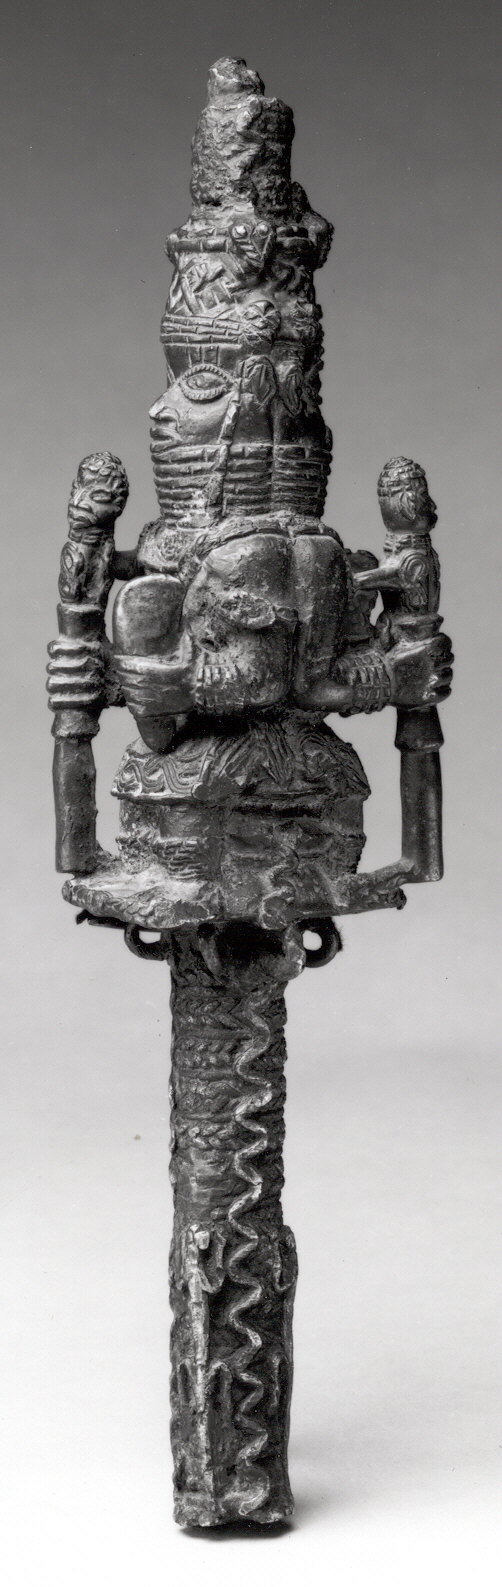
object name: staff fragment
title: Staff Fragment: Seated Oba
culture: edo period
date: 1701-1900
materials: brass, iron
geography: nigeria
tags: men